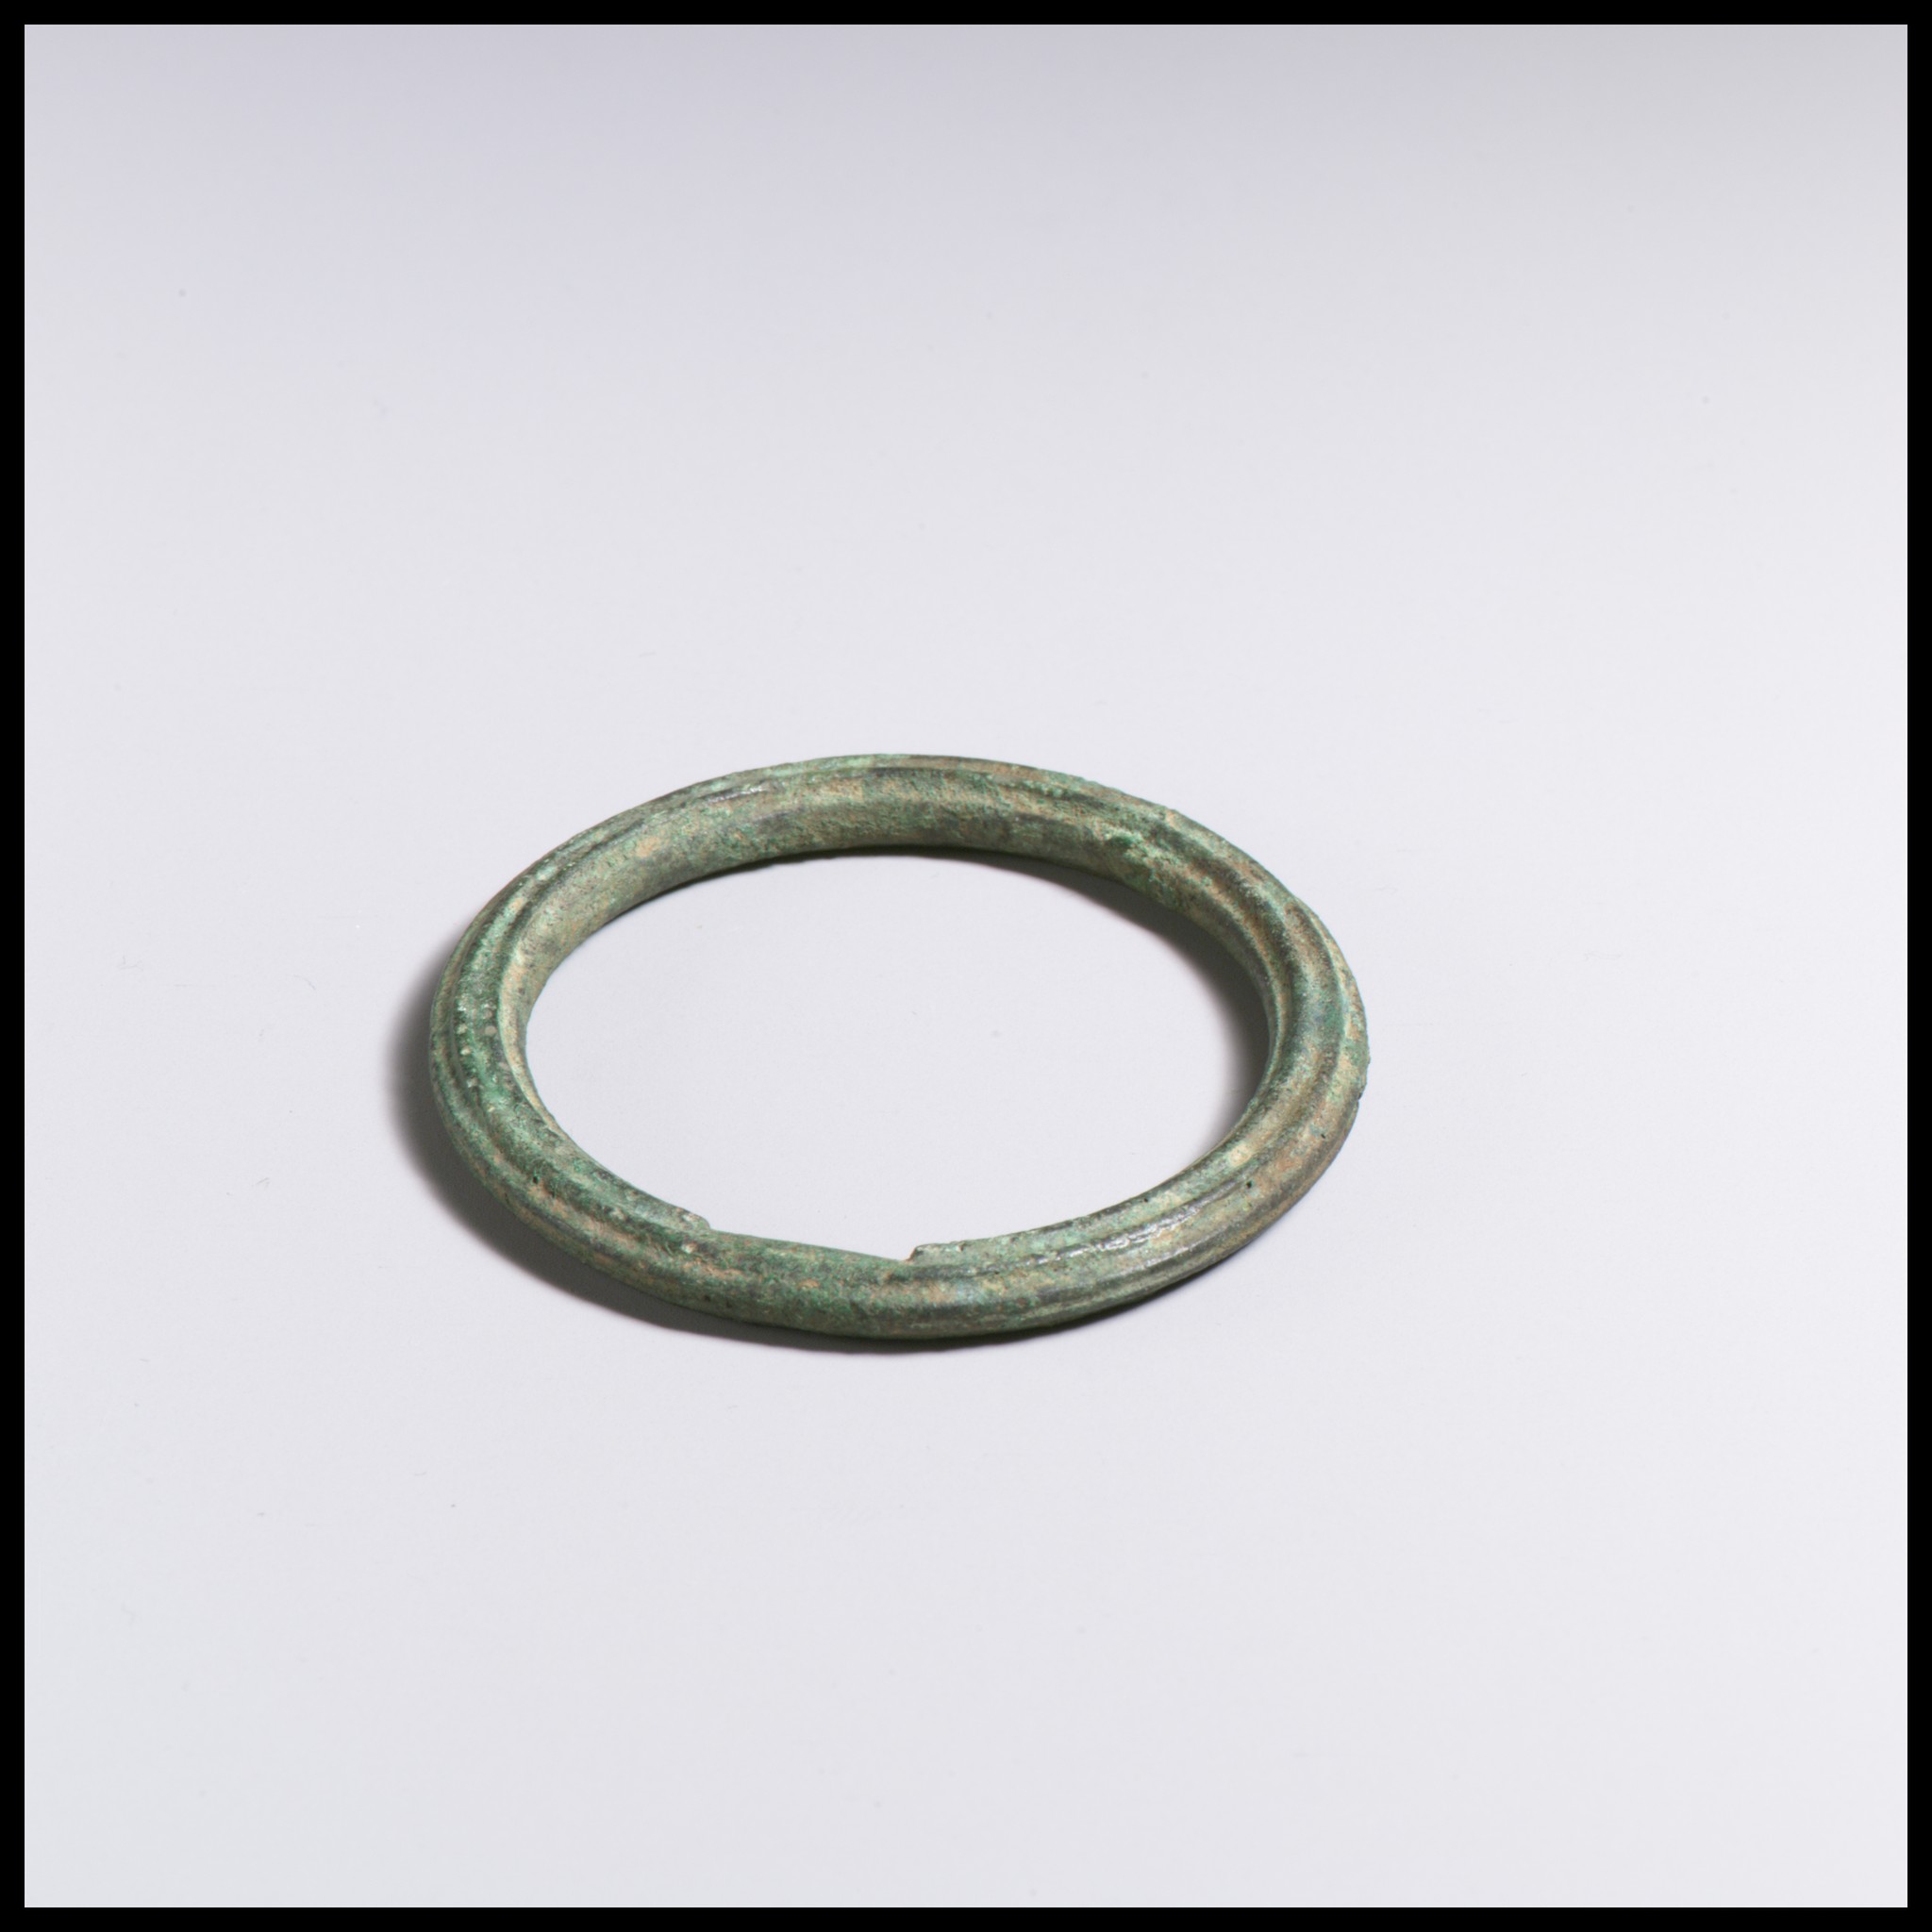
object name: ring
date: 7000 BCE-330 CE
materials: bronze